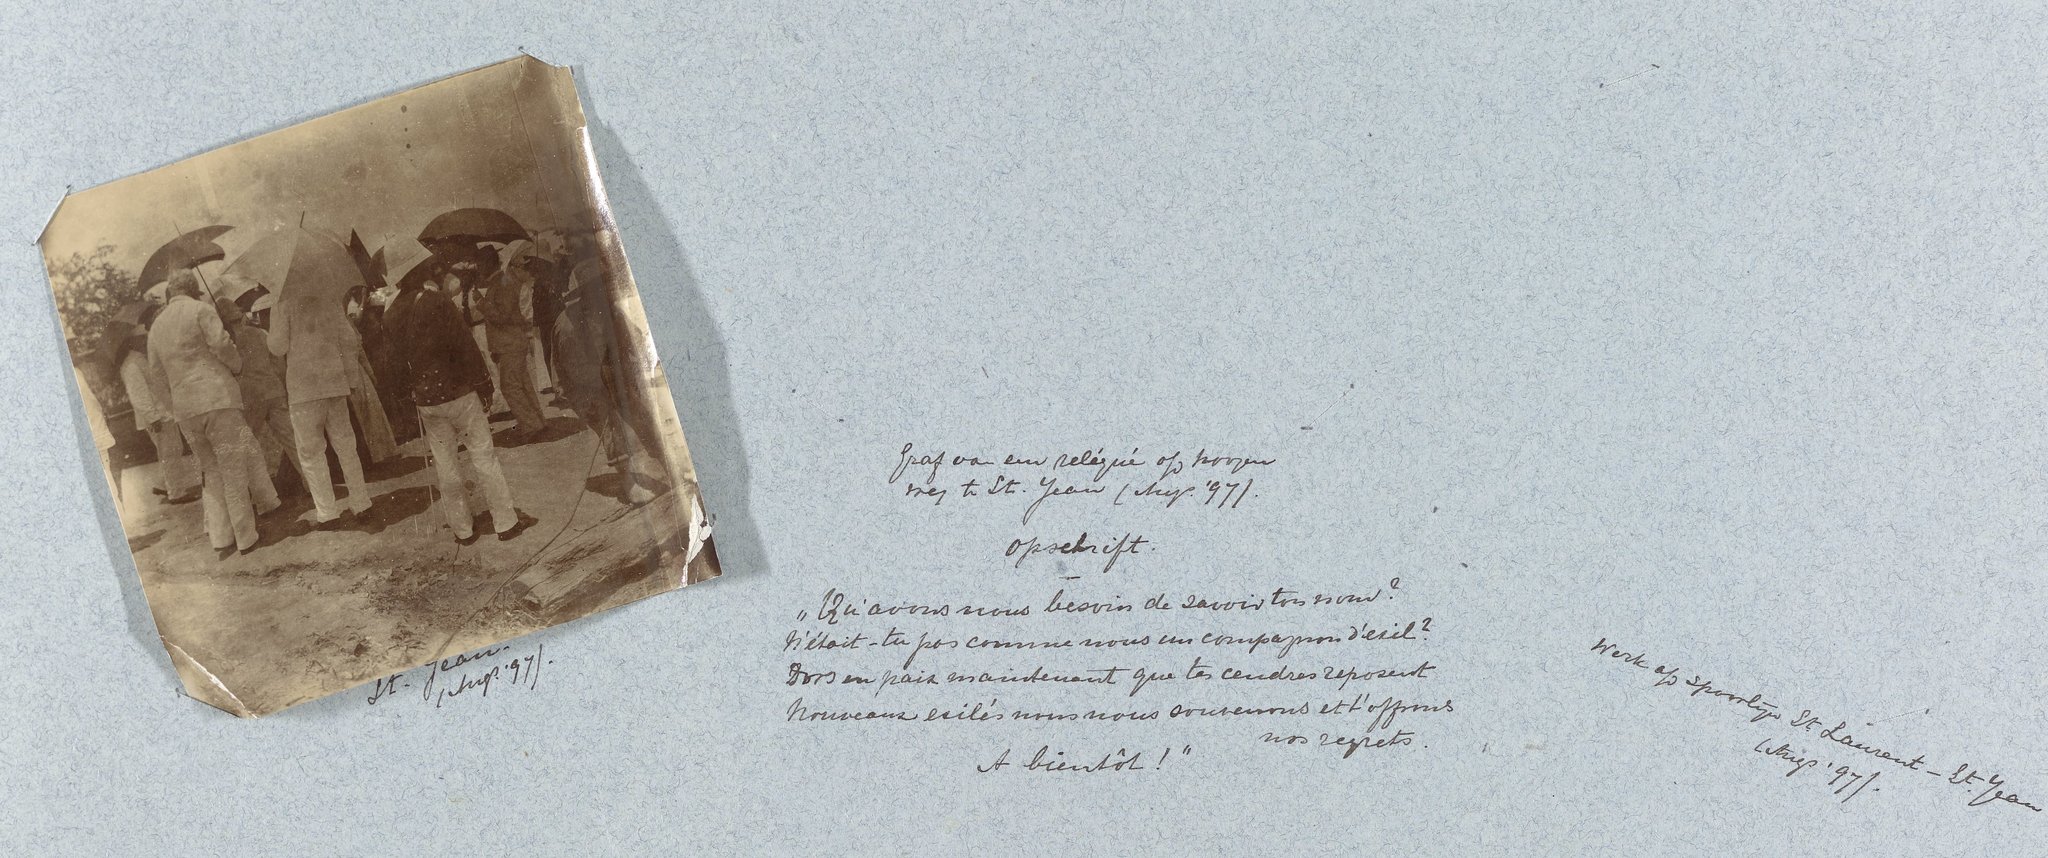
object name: photograph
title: St. Jean. (Augs. '97)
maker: théodore van lelyveld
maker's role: painter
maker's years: 1867-1954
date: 1808-1897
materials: photographic support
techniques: collodion silver print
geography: suriname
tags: workhouse, penal camp, penitentiary, chain gang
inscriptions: inscription: ‘St. Jean. (Augs. '97)’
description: Tijdens het bezoek aan de Franse strafkolonie te St. Jean (Saint-Jean-du-Maroni) in Guyana, augustus 1897. Een groep Europese mannen met parasols, voornamelijk op de rug gezien. Fotoafdruk in een fotoalbum van Théodore van Lelyveld over Suriname uit 1895-1898.